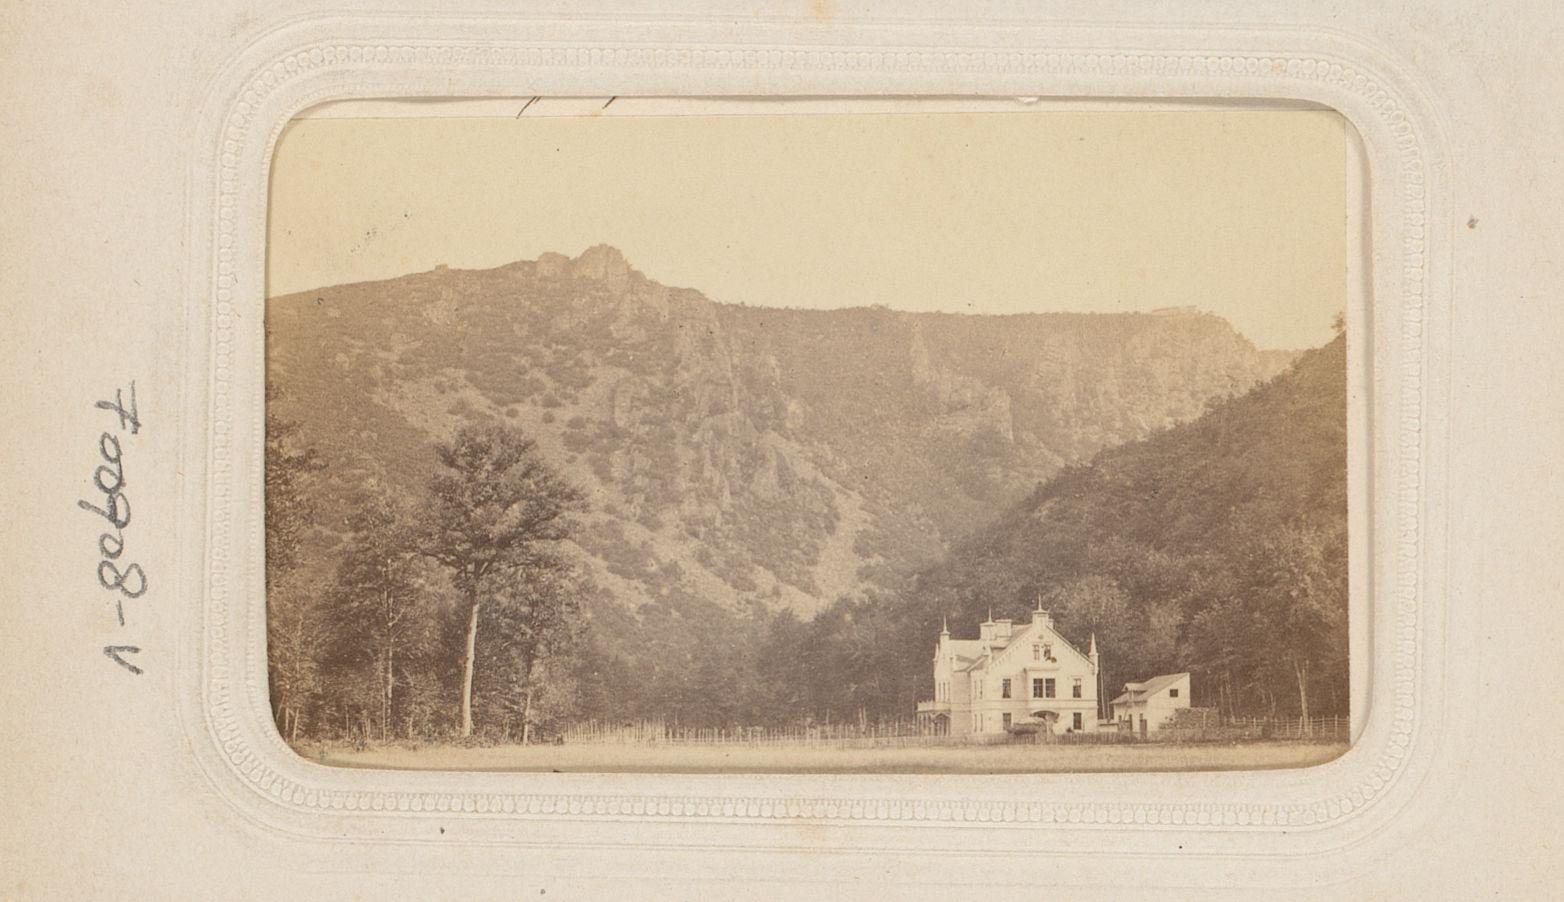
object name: album leaf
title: Huis aan de rand van Bodetal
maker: berthold woltze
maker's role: painter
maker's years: 1829-1896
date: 1860-1890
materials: cardboard, photographic support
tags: ravine (in tropical and sub-tropical regions), rural housing, e.g. country-house, villa, cottage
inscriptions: annotation: ‘Ingang Bodethal’, inscription: ‘Berthold Woltze/ Maler & Photograph/ in/ Halberstadt/ Breite Weg 601’, annotation: ‘Ingang Bodedal’, annotation: ‘De Harz, Hexentanzplatz’